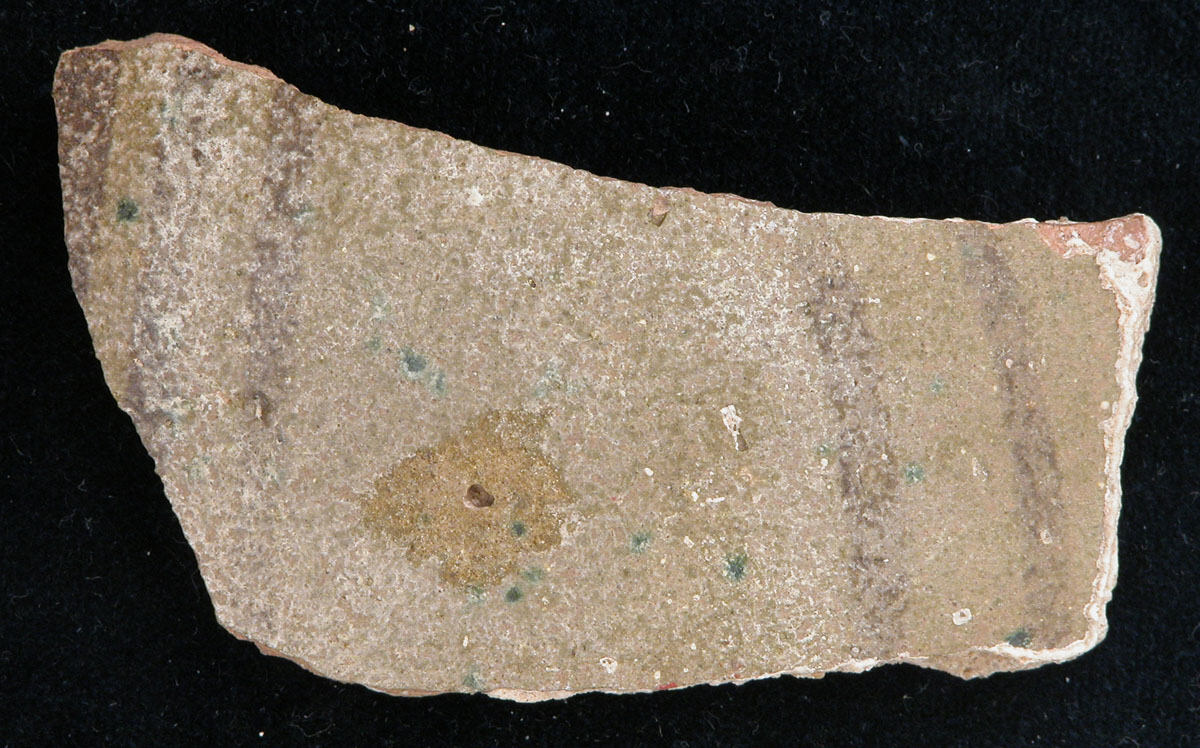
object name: fragment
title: Ceramic Fragment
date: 801-1000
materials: earthenware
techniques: glazing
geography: saudi arabia